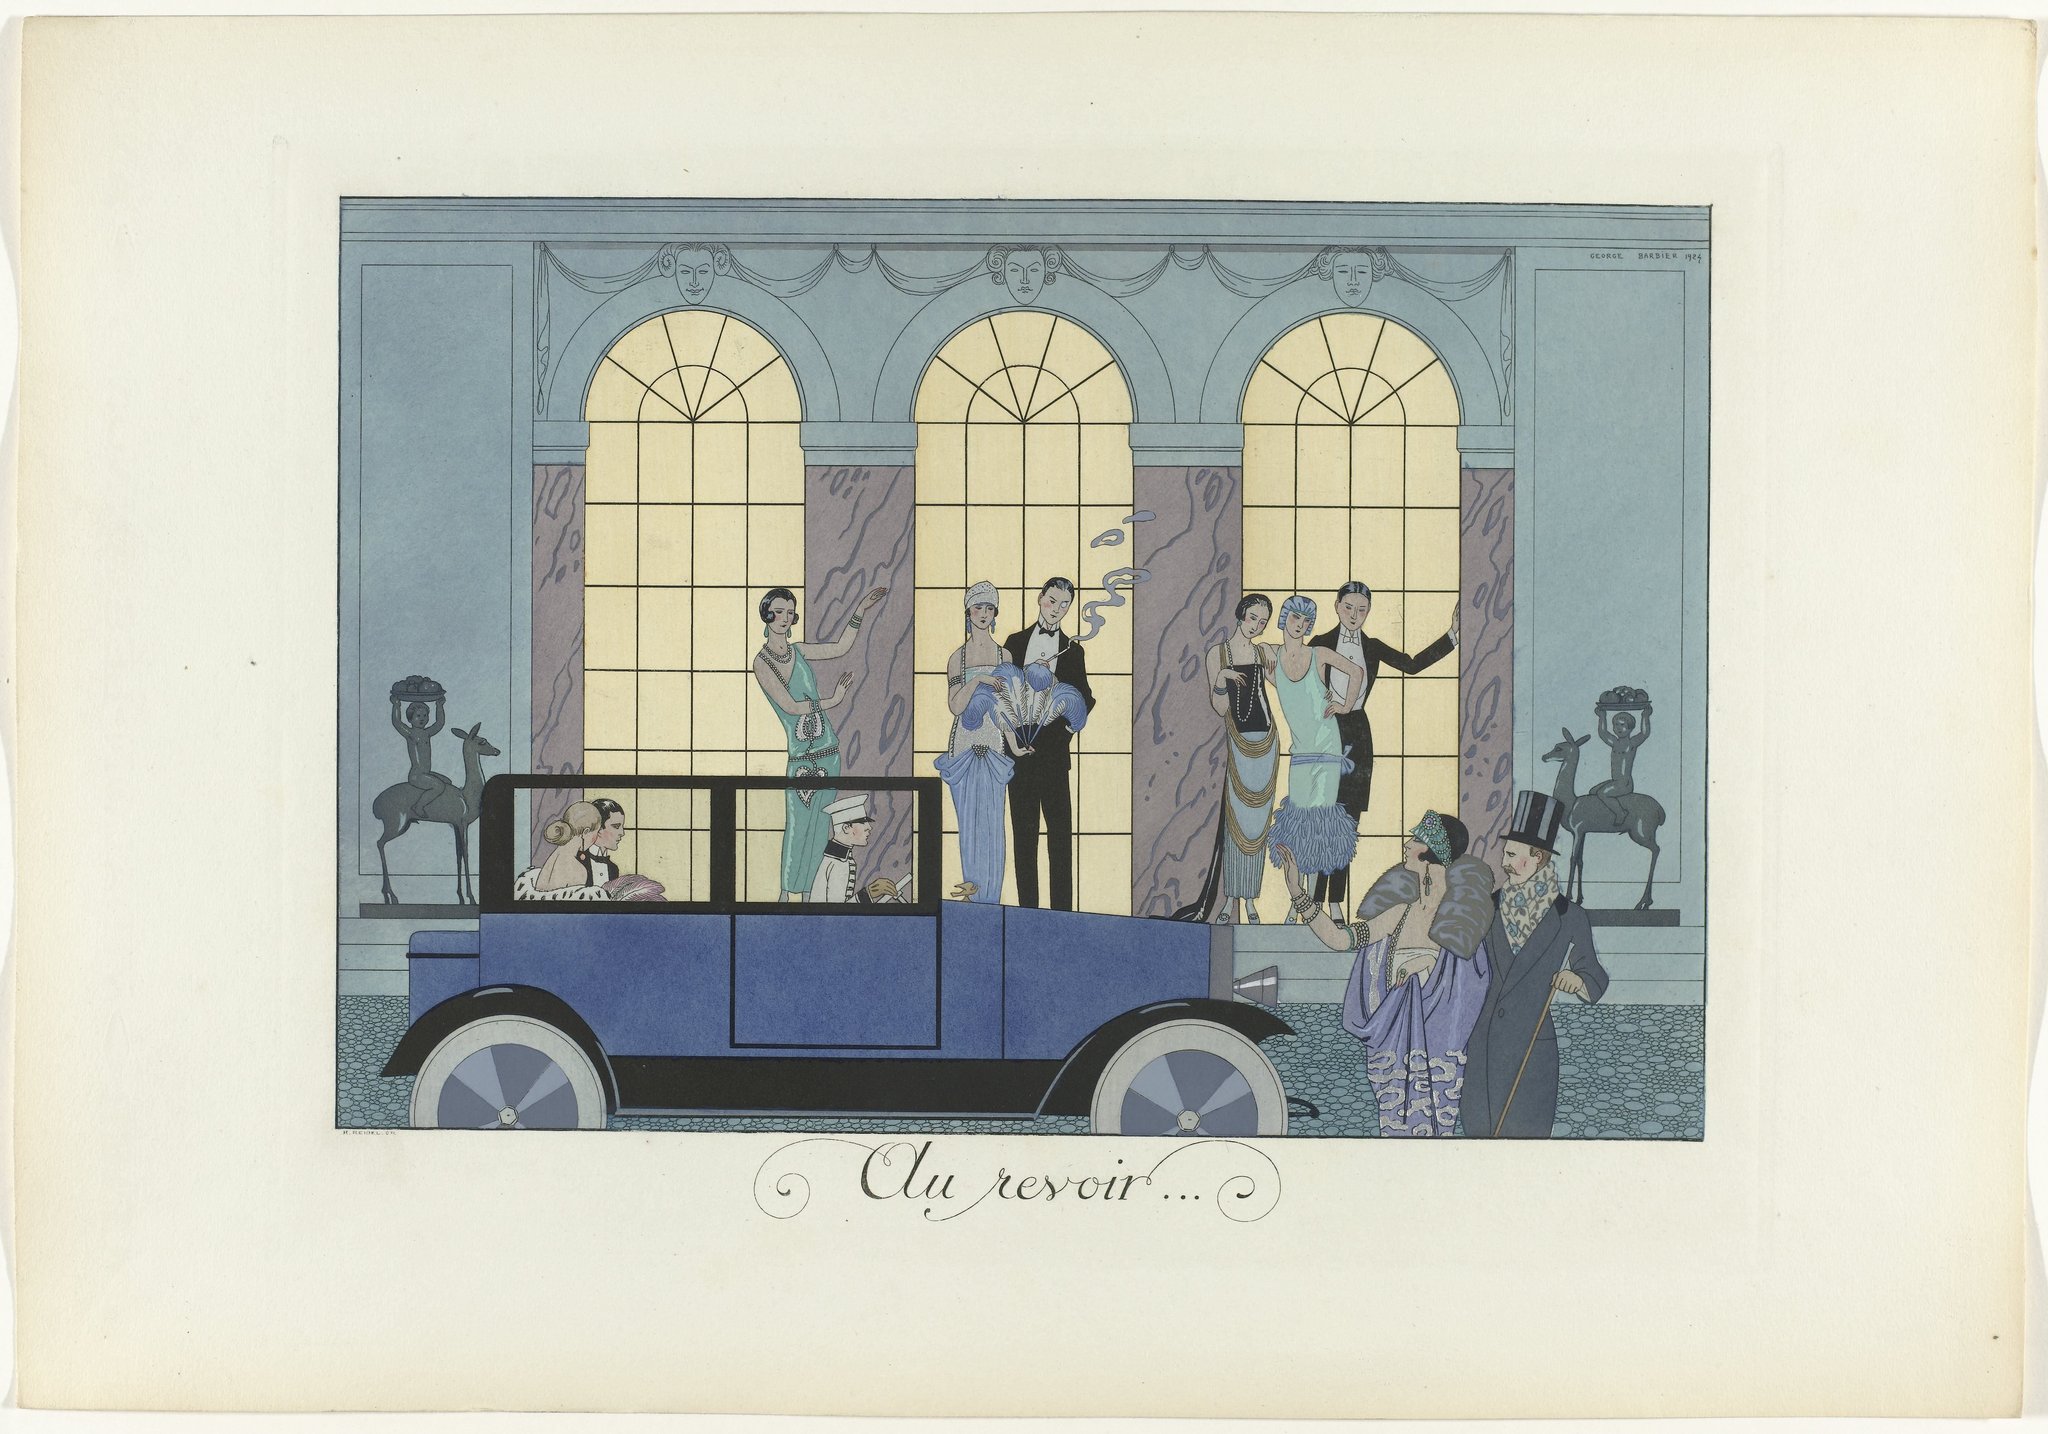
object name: fashion print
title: Joie de vivre: Le Bonheur du Jour ou Les Graces à la Mode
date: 1924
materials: paper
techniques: engraving, hand coloring, pochoir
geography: paris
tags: dress, gown: evening dress (+ women's clothes), fashion plates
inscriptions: date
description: Luxuriously produced fashion series by artists immerse the reader in a world of exotic colours and joie de vivre. George Barbier writes in the introduction of Le Bonheur du Jour that everything in his album delights the eye: extravagant clothing, feather fans, amorous entangle-ments, and pleasant diversion.